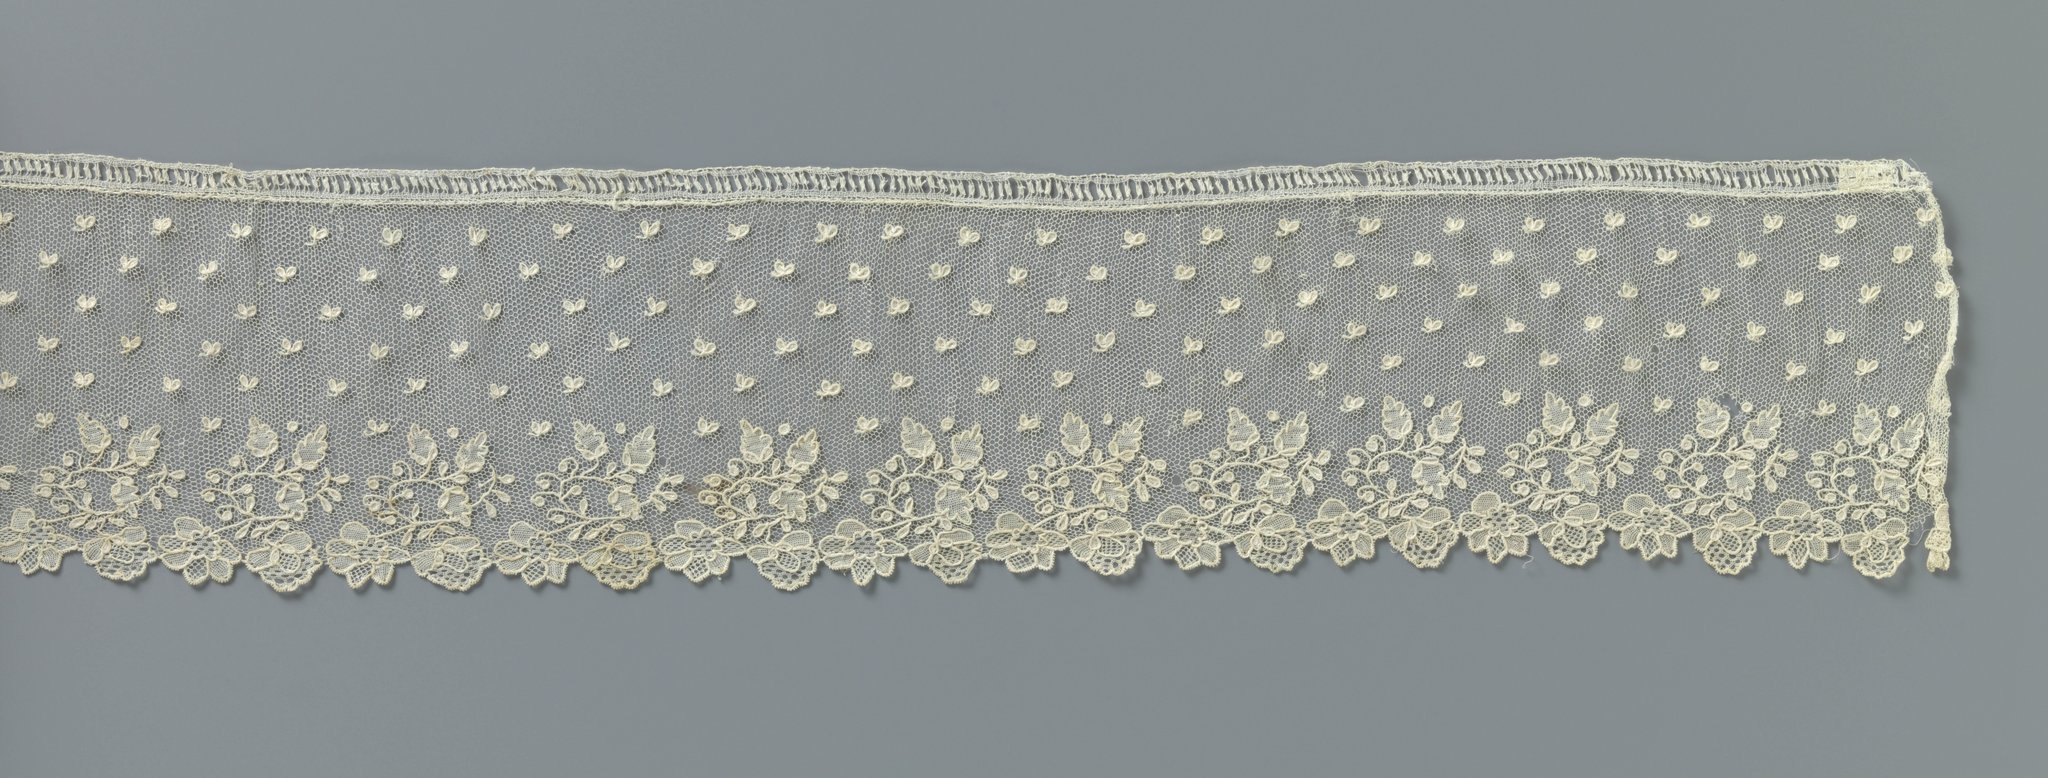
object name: strip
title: Strook naaldkant met aardbeitakjes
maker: Anonymous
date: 1825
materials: linen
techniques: lace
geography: france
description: Een brede rand vertoont paarsgewijs kruisende gebogen bladtakjes met neerhangende aardbeibloempjes en -vruchtjes, die diepe schulpjes vormen. Op de grond staan gestrooide dubbelblaadjes. Alençon-kant.